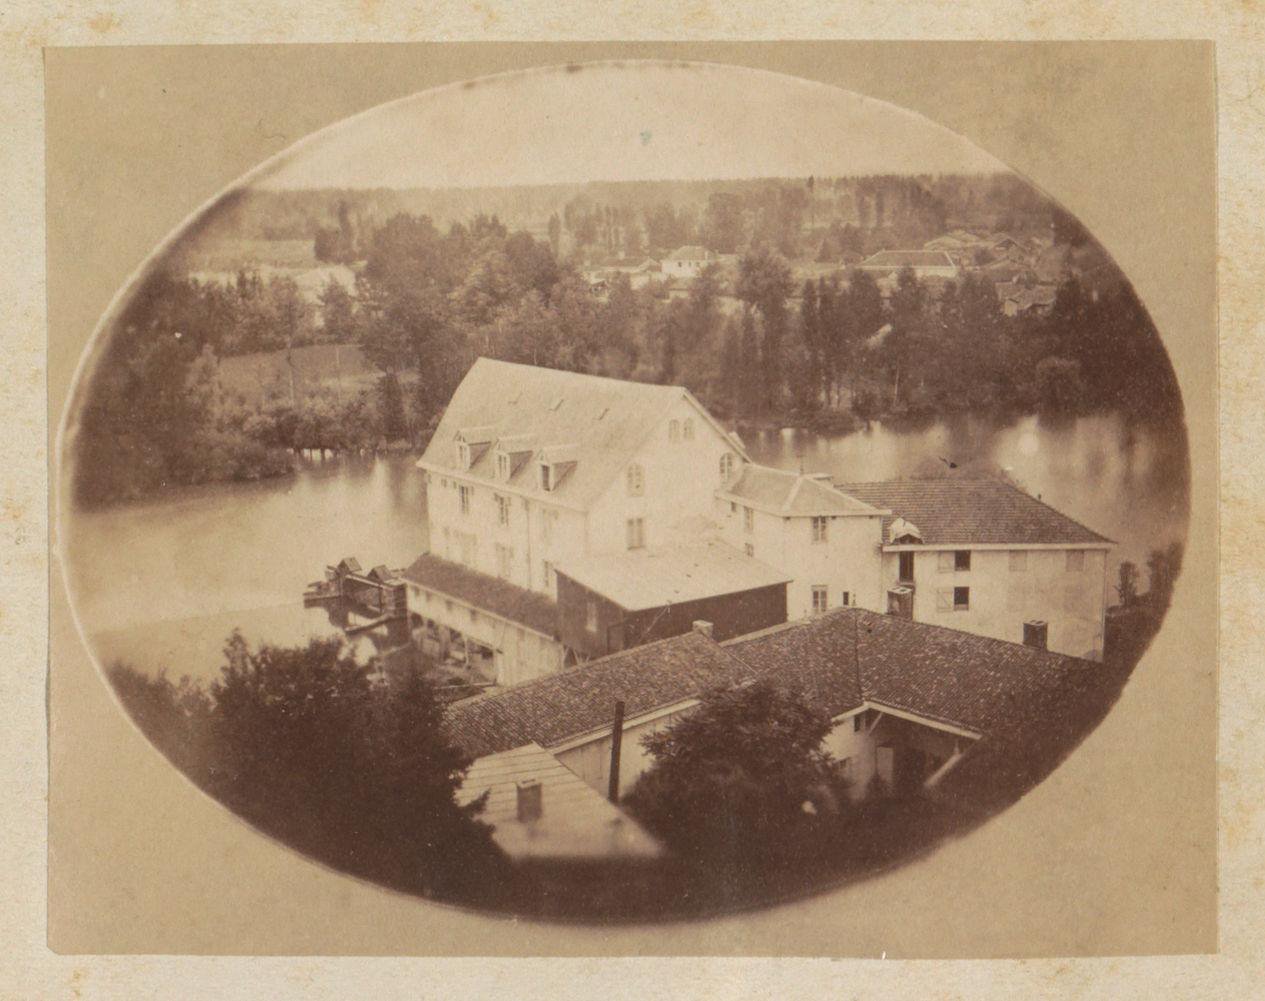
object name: photograph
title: Gezicht op een dorp aan een rivier in Frankrijk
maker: Anonymous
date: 1883-1886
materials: photographic support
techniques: albumen print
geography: france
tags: prospect of village, silhouette of village, river (+ landscape with figures, staffage), france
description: Onderdeel van Album van een Franse amateurfotograaf met opnames van familie, militairen, industrie, landschappen en bezienswaardigheden in Frankrijk.